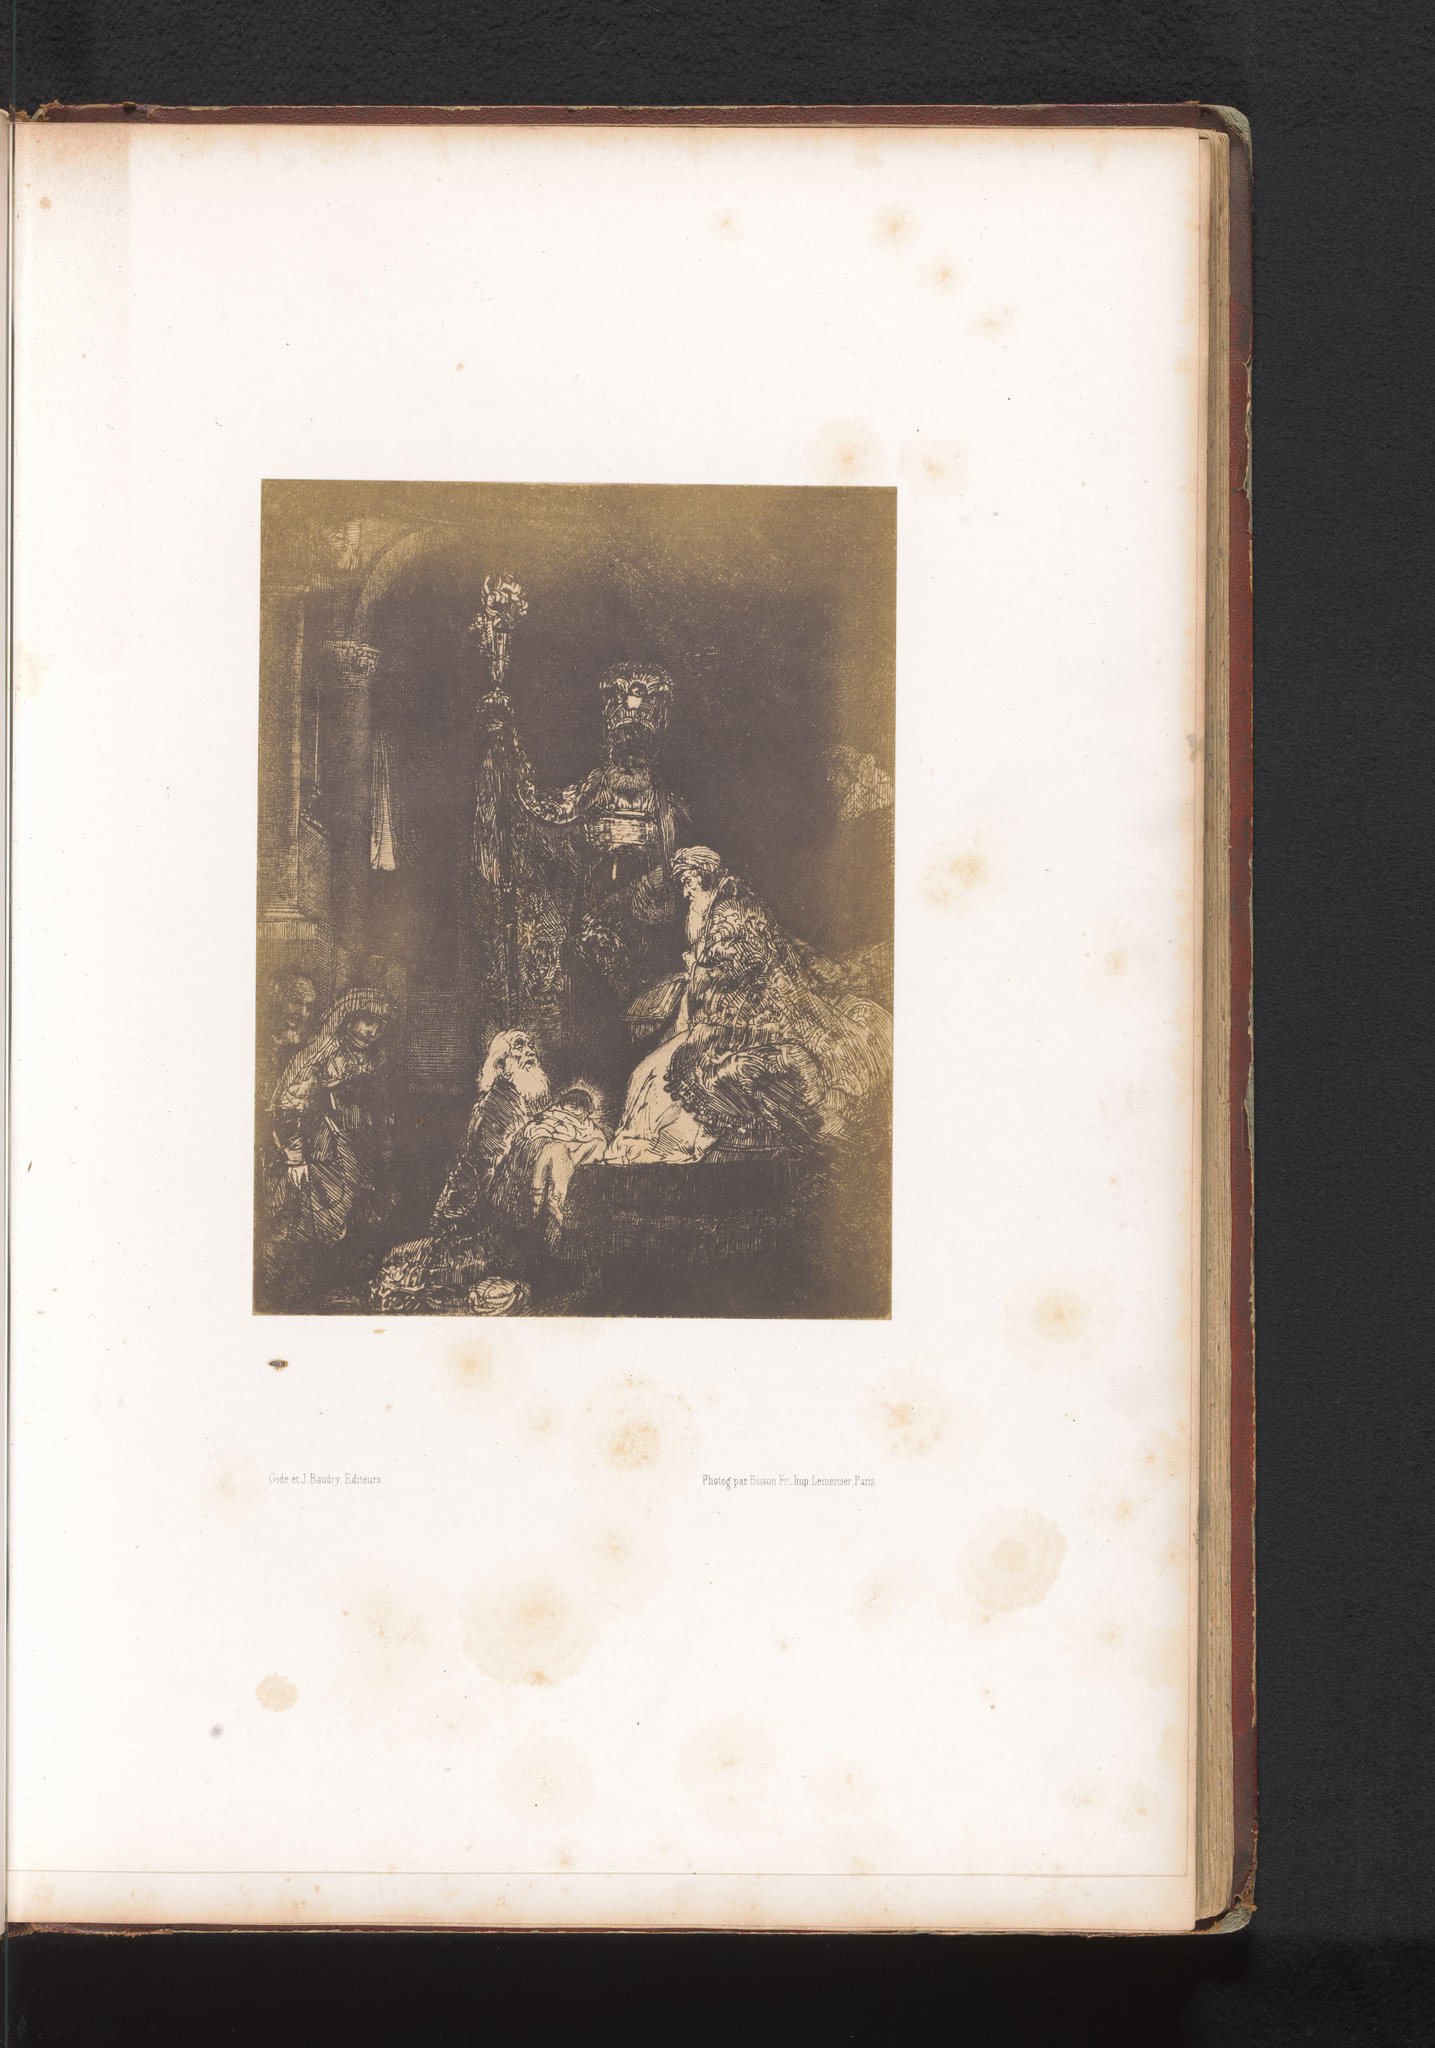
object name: page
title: Fotoreproductie van een ets van de presentatie van Christus in de tempel door Rembrandt van Rijn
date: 1848-1853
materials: photographic support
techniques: salted paper print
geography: paris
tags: presentation of the christ-child in the temple, usually simeon (and anna) present (luke 2:22-39)